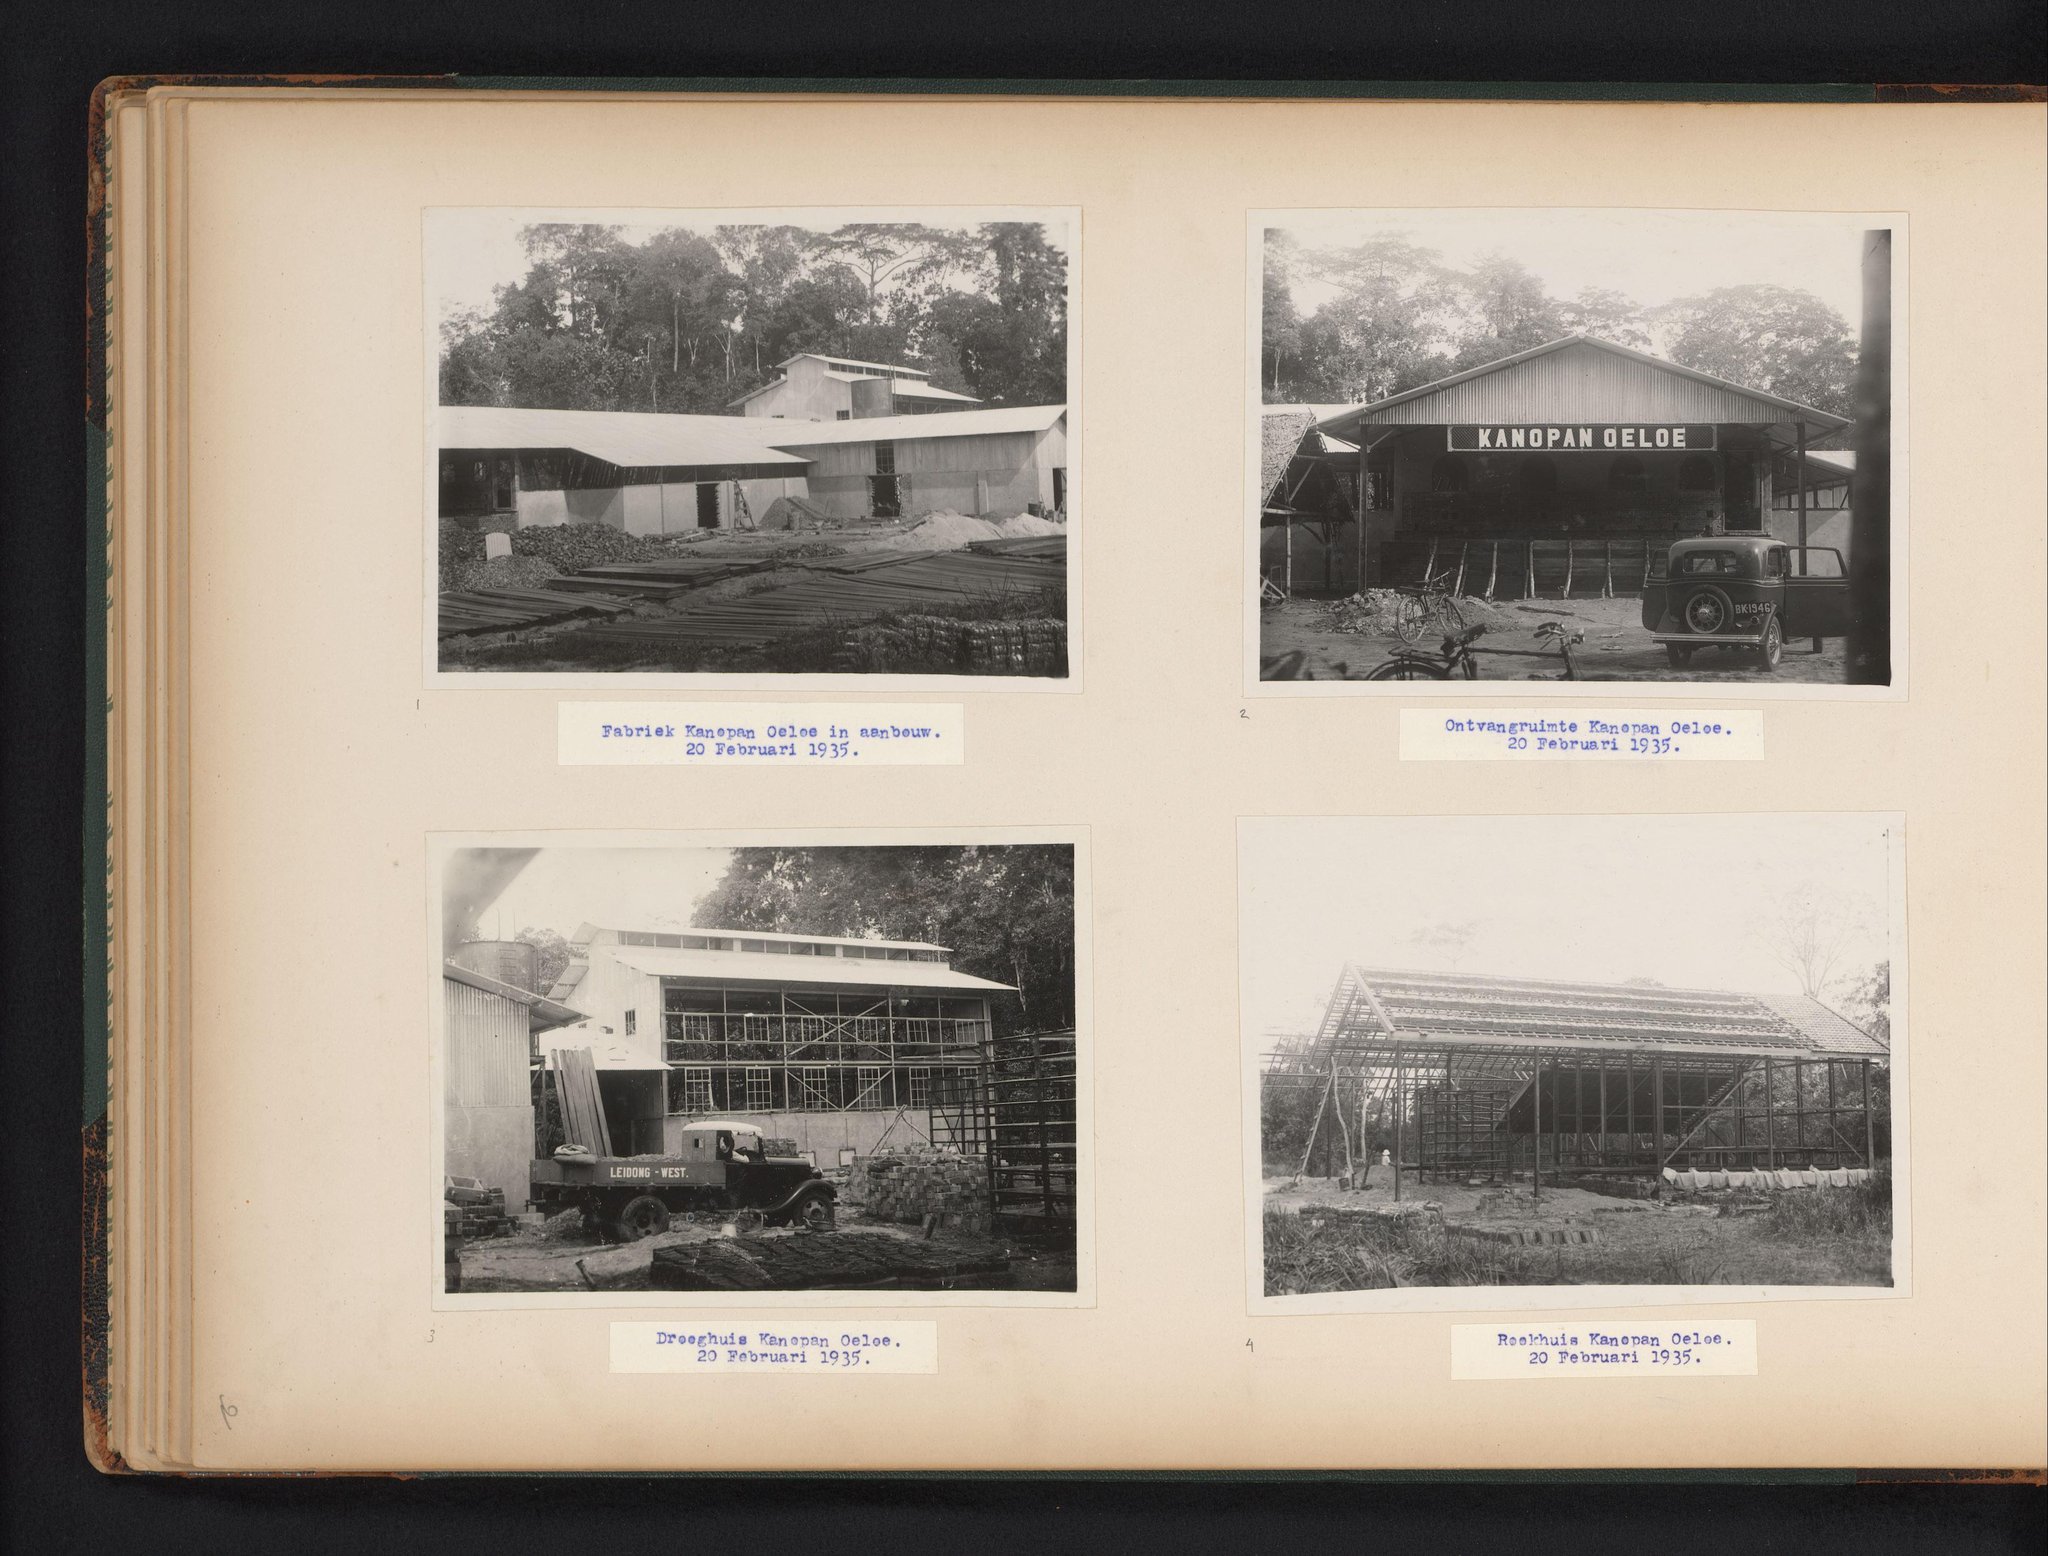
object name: photograph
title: Bedrijfsgebouwen op Kanopan Oeloe, 1935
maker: Anonymous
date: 1935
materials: cardboard, photographic support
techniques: gelatin silver print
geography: sumatra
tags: truck, van, plantation, (non-fruit) products of plants or trees: rubber, exterior of industrial structures, factories, automobile, sumatra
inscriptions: inscription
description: Blad met vier foto's van bedrijfsgebouwen op Kanopan Oeloe, februari 1935. Onderdeel van het fotoalbum over de plantages Leidong West en Kanopan Oeloe van de Cultuur Maatschappij Leidong West op Sumatra in de jaren 1925-1939.